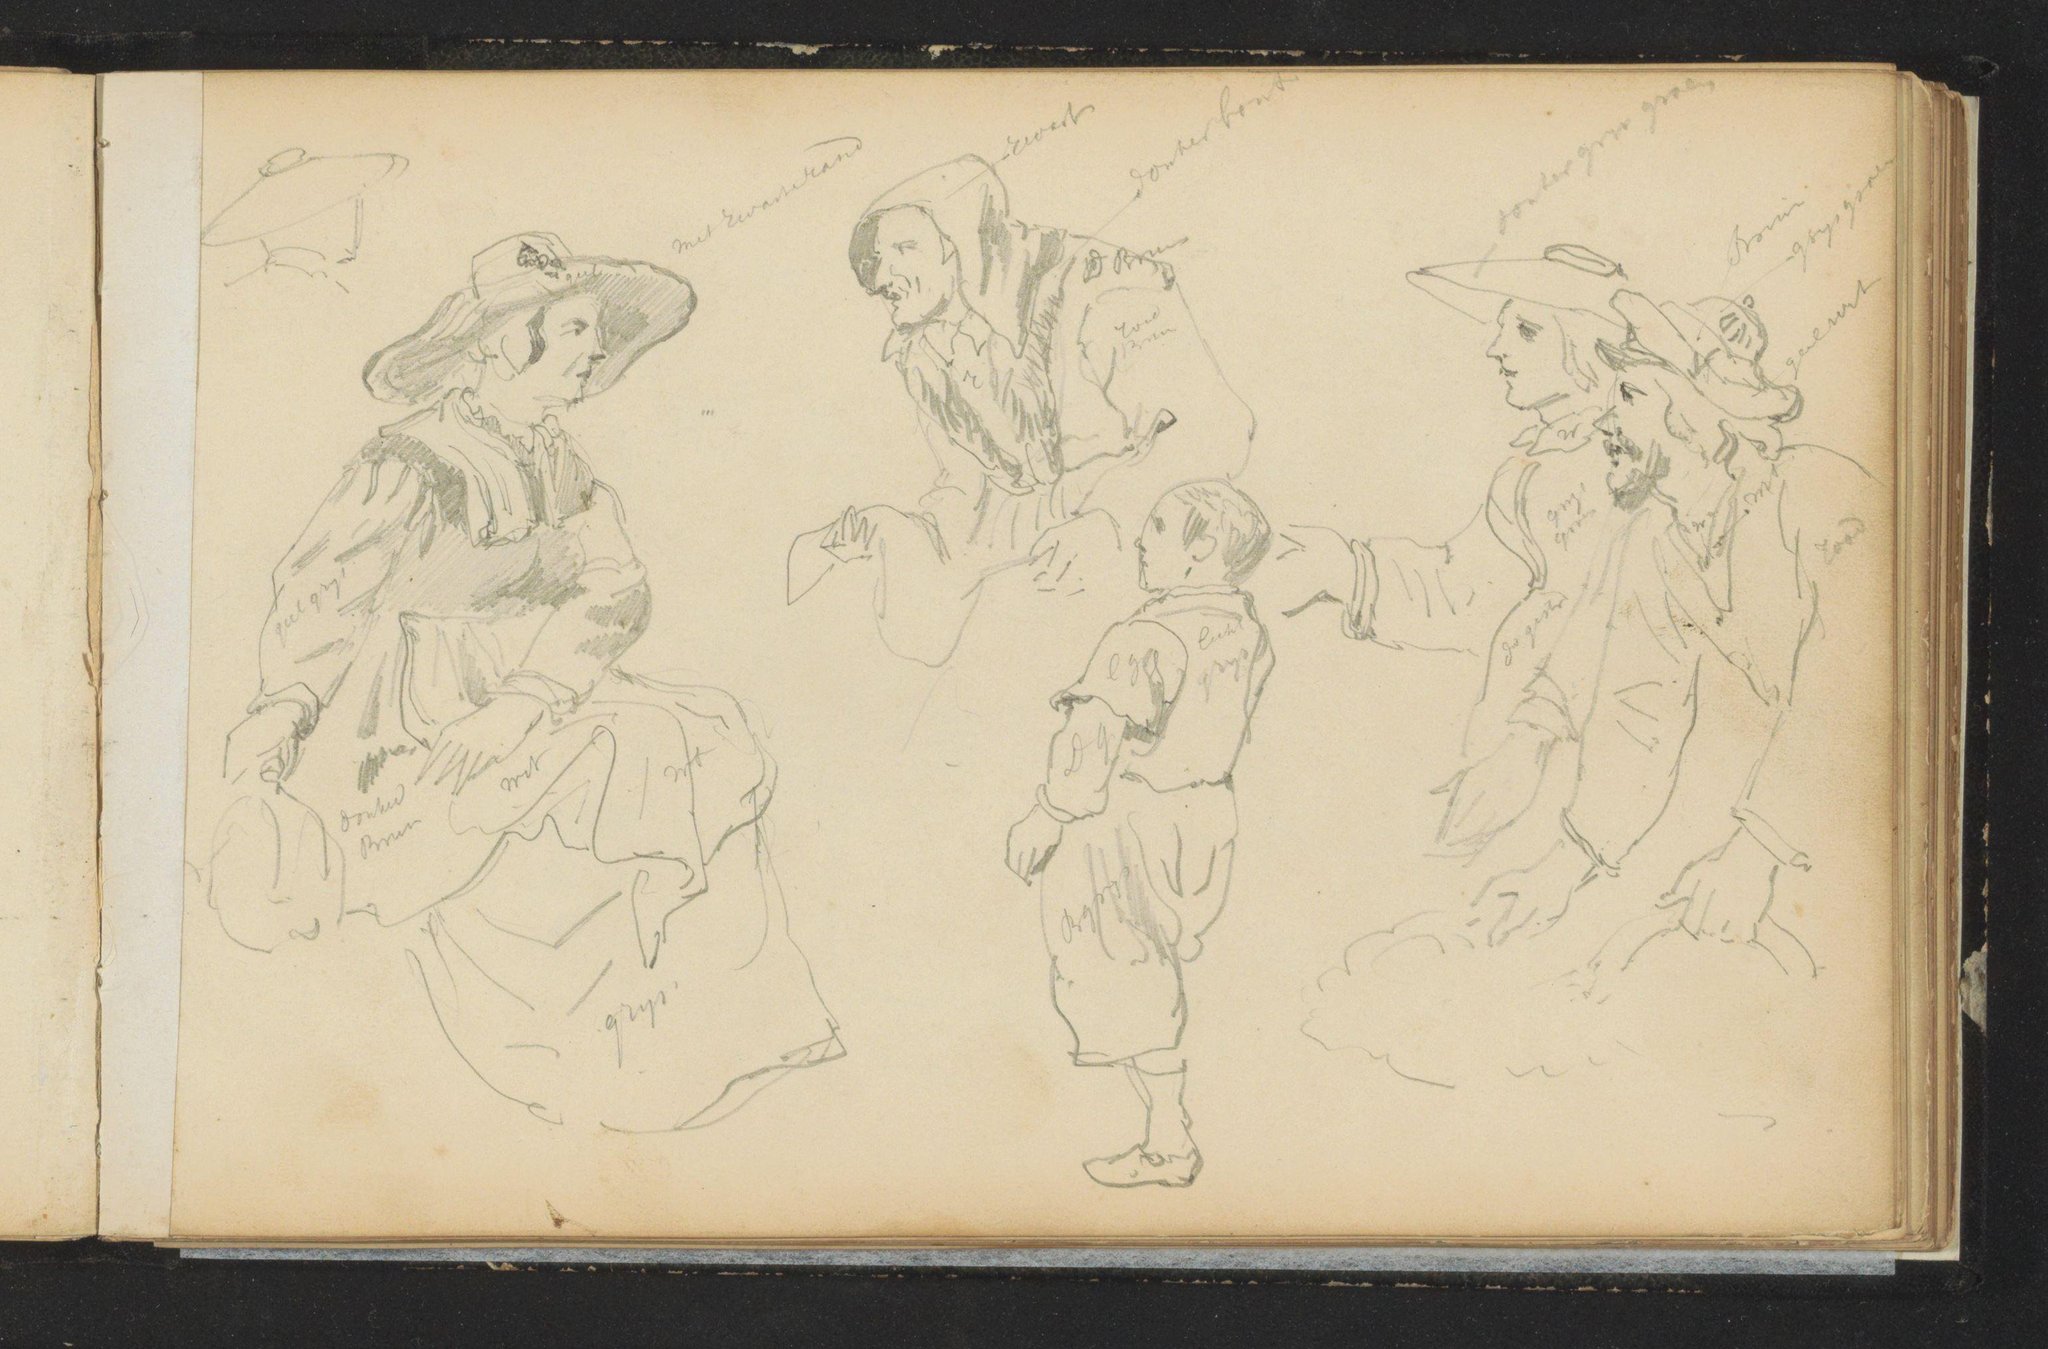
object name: sketchbook leaf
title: Figuren in verschillende houdingen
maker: cornelis springer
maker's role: draughtsman, painter, print maker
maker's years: 1817-1891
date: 1846-1882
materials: paper, pencil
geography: netherlands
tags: adult woman, boy (child between toddler and youth), adult man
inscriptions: kleurnotitie, handgeschreven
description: Vrouwen, mannen en een jongen in verschillende houdingen. Blad 45 uit een schetsboek met 91 bladen.